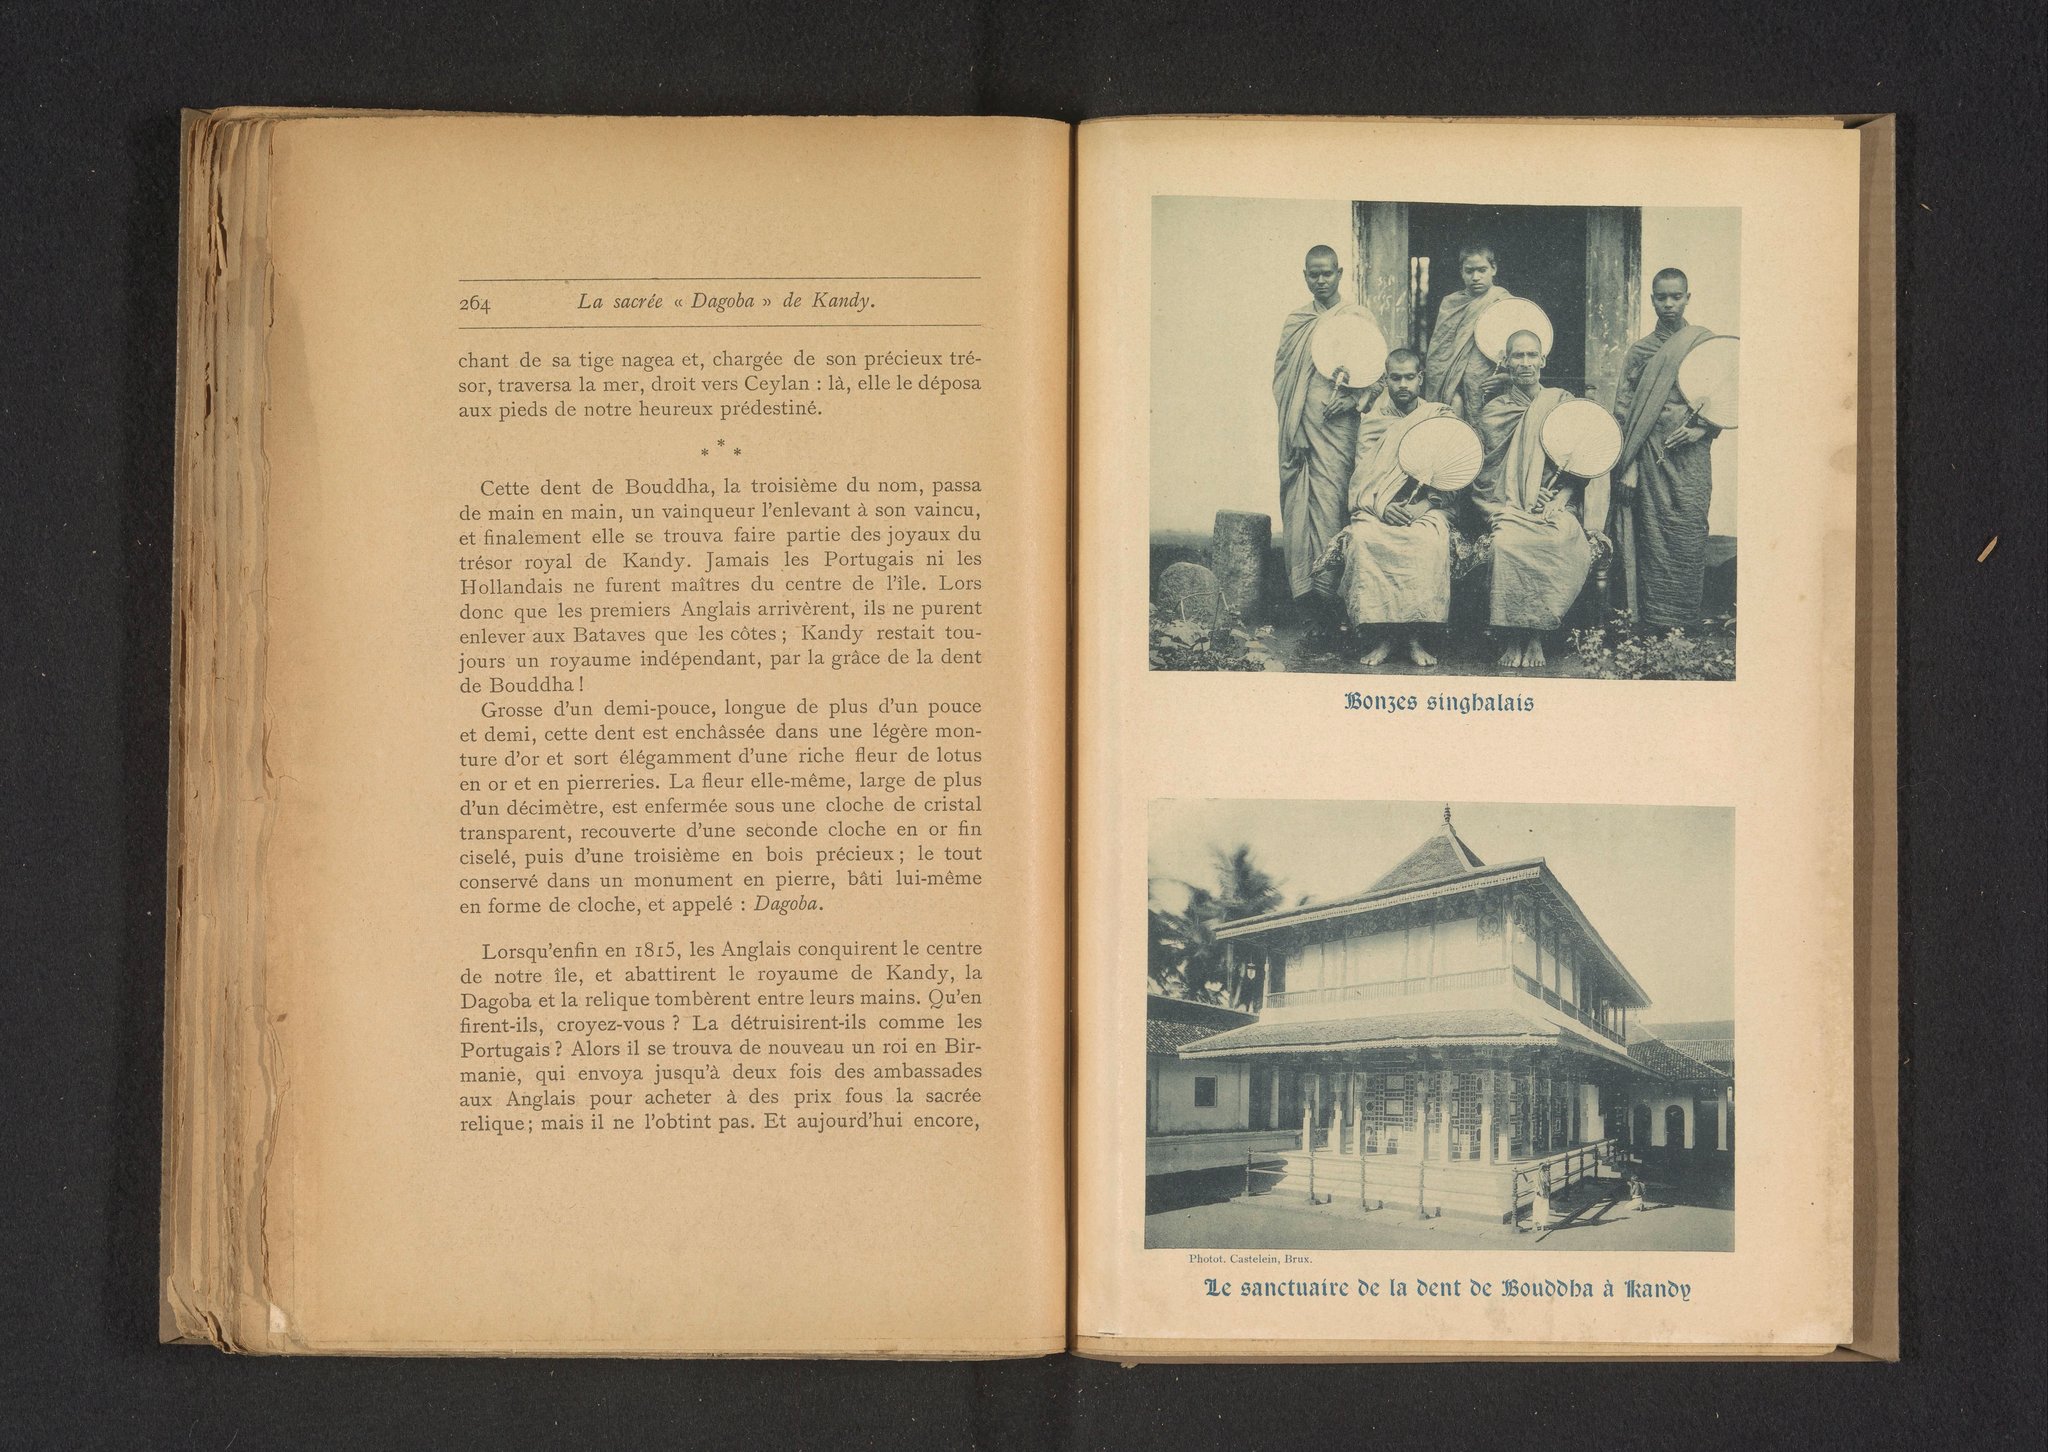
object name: page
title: Bonzes singhalais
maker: e. castelein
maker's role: printer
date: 1894-1899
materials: paper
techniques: photograph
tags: monk(s), friar(s), anonymous historical persons portrayed in a group, in a group-portrait, sri lanka